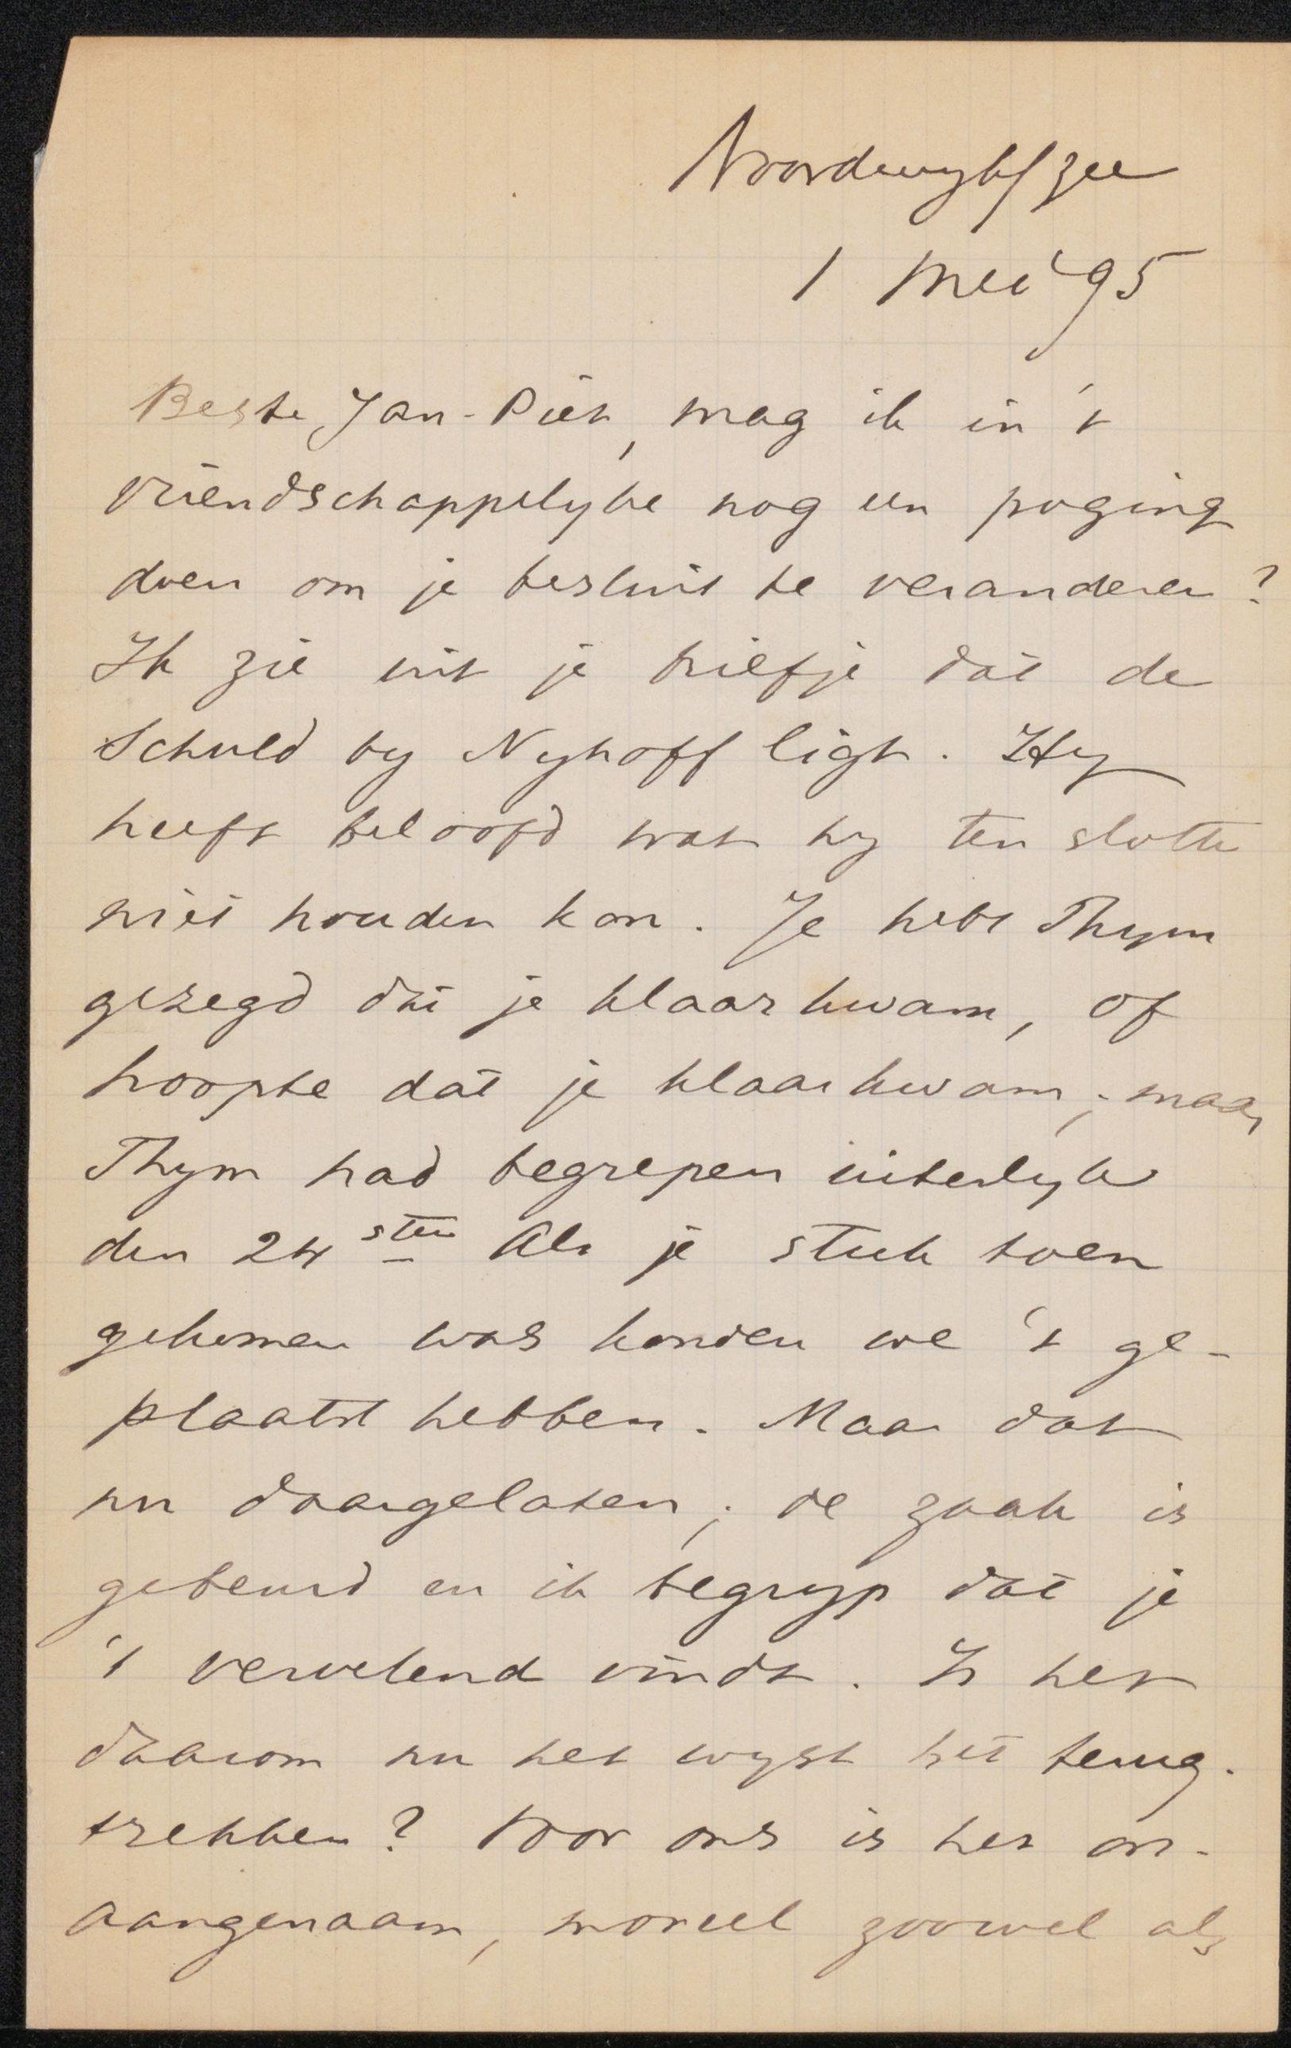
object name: letter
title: Brief aan Jan Veth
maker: albert verwey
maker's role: criticus, dichter, essayist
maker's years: 1865-1937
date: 1895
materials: ink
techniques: pen, writing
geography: noordwijk aan zee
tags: painter, draughtsman, designer, jan veth, lodewijk van deyssel, arnhem, the hague, publisher, martinus nijhoff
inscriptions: collector's mark: ‘RPK’